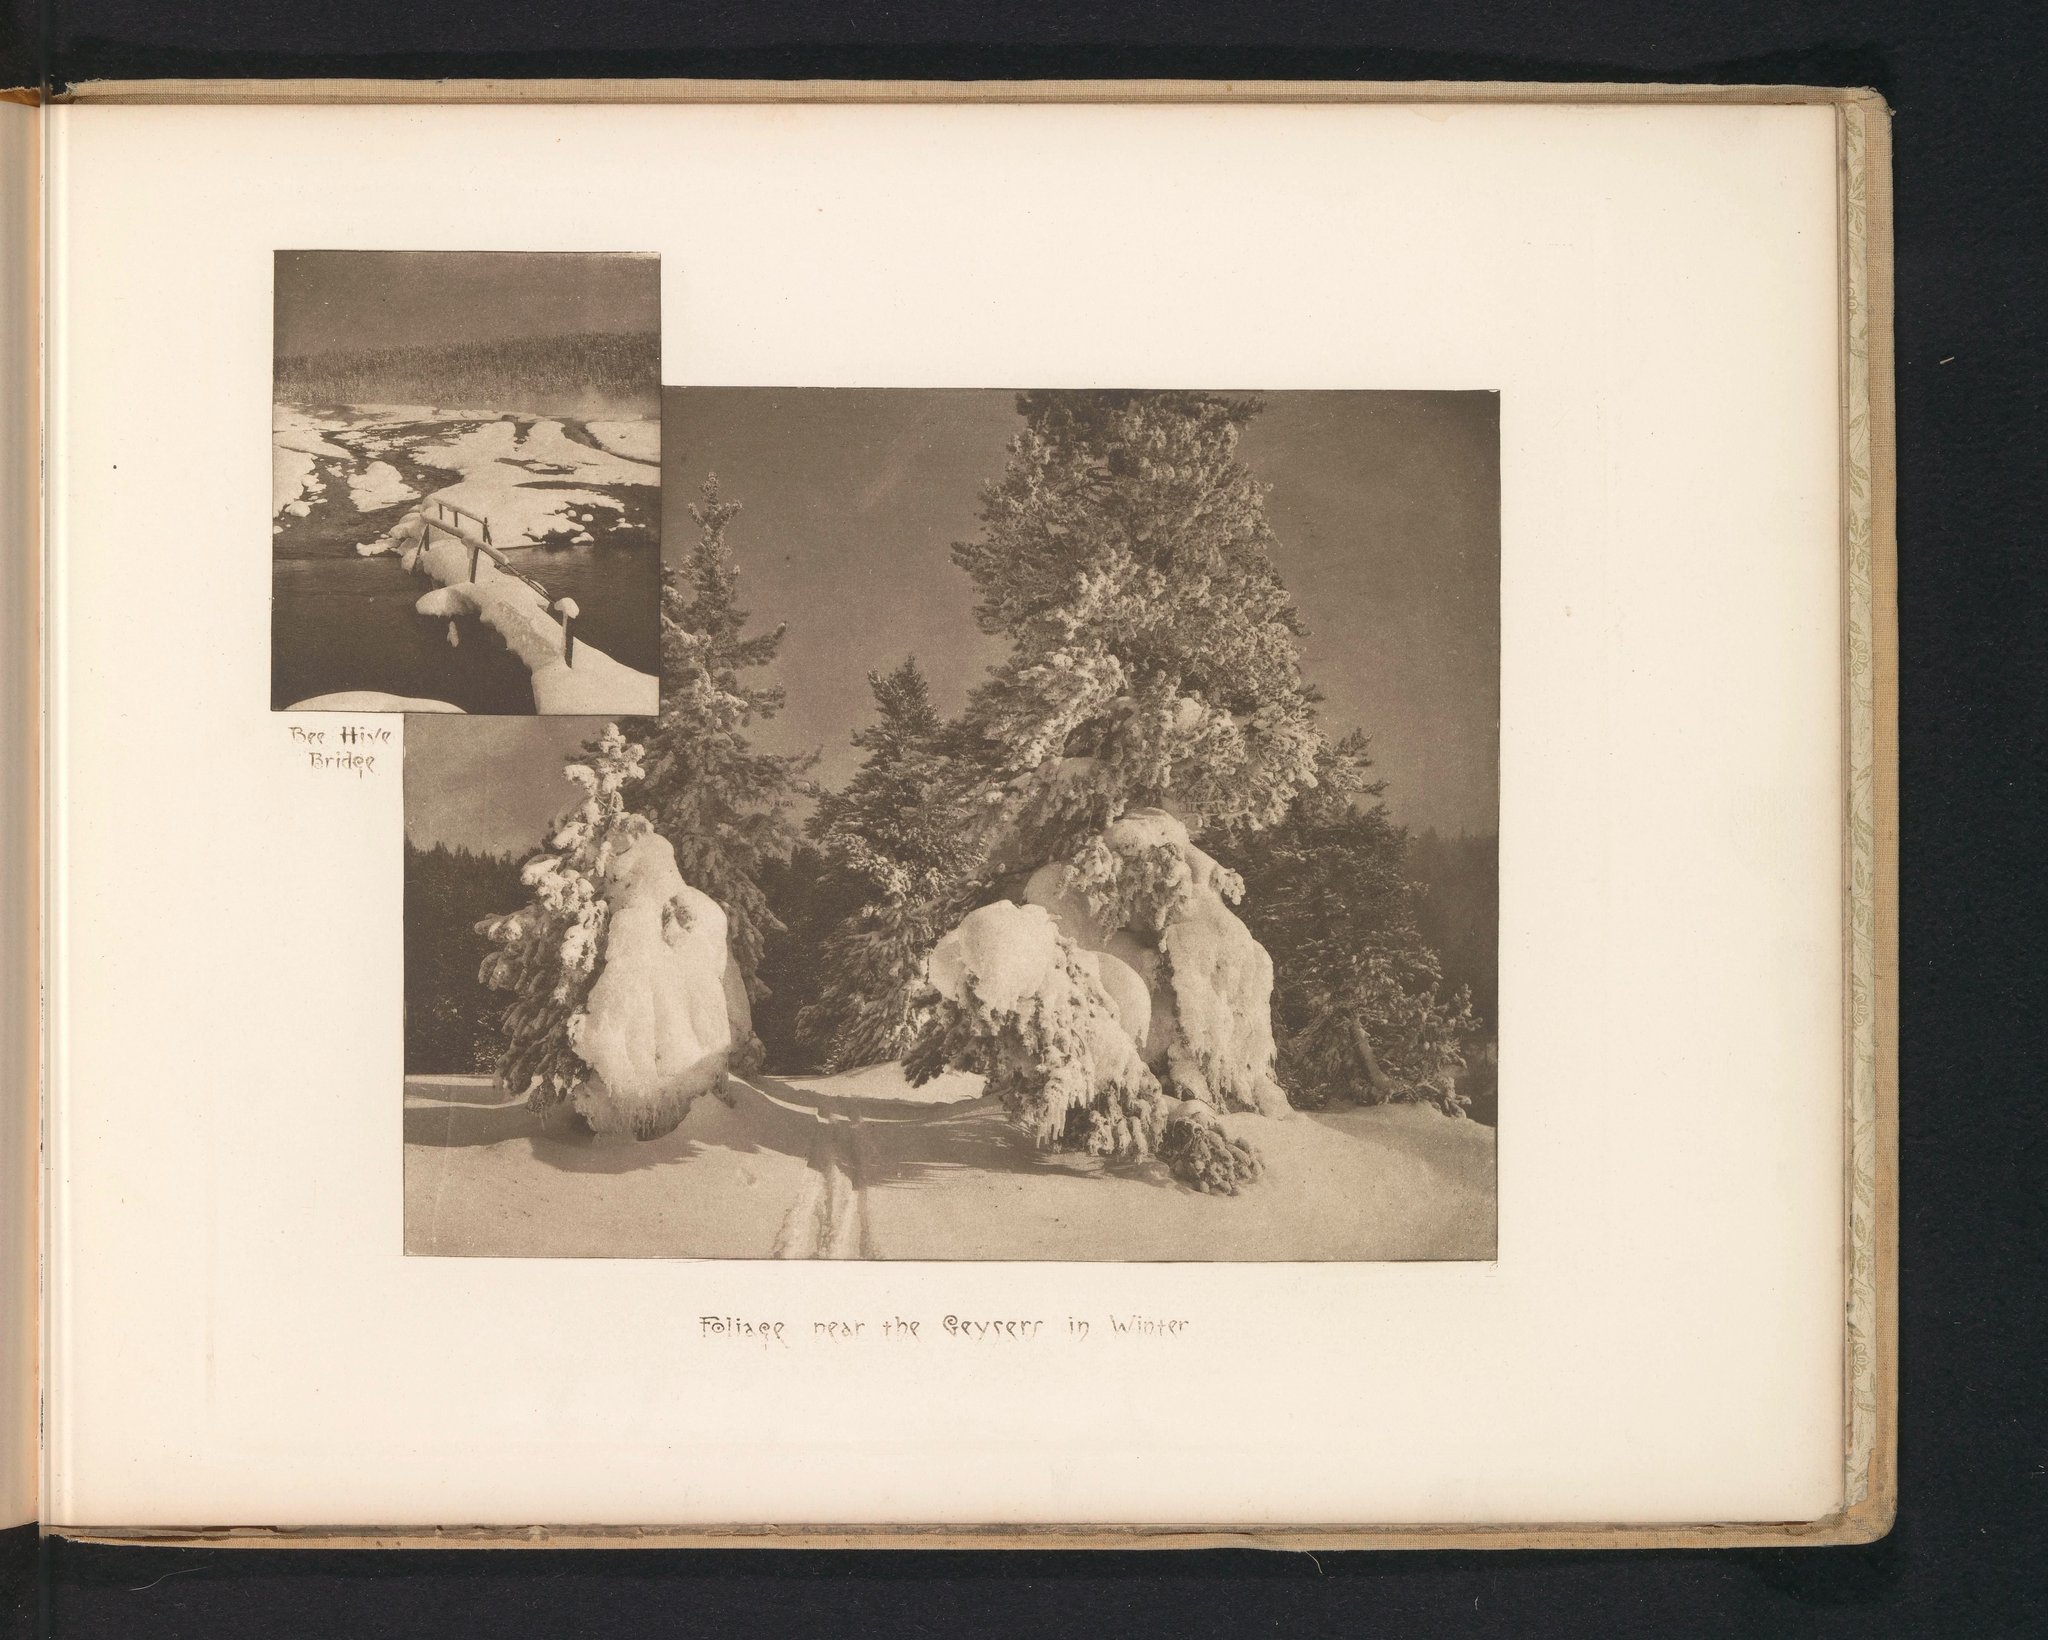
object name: page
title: Bee Hive bridge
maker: frank jay haynes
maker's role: fotograaf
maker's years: 1853-1921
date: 1882-1887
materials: paper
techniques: photoaquatint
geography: new york city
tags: forest, wood, bridge